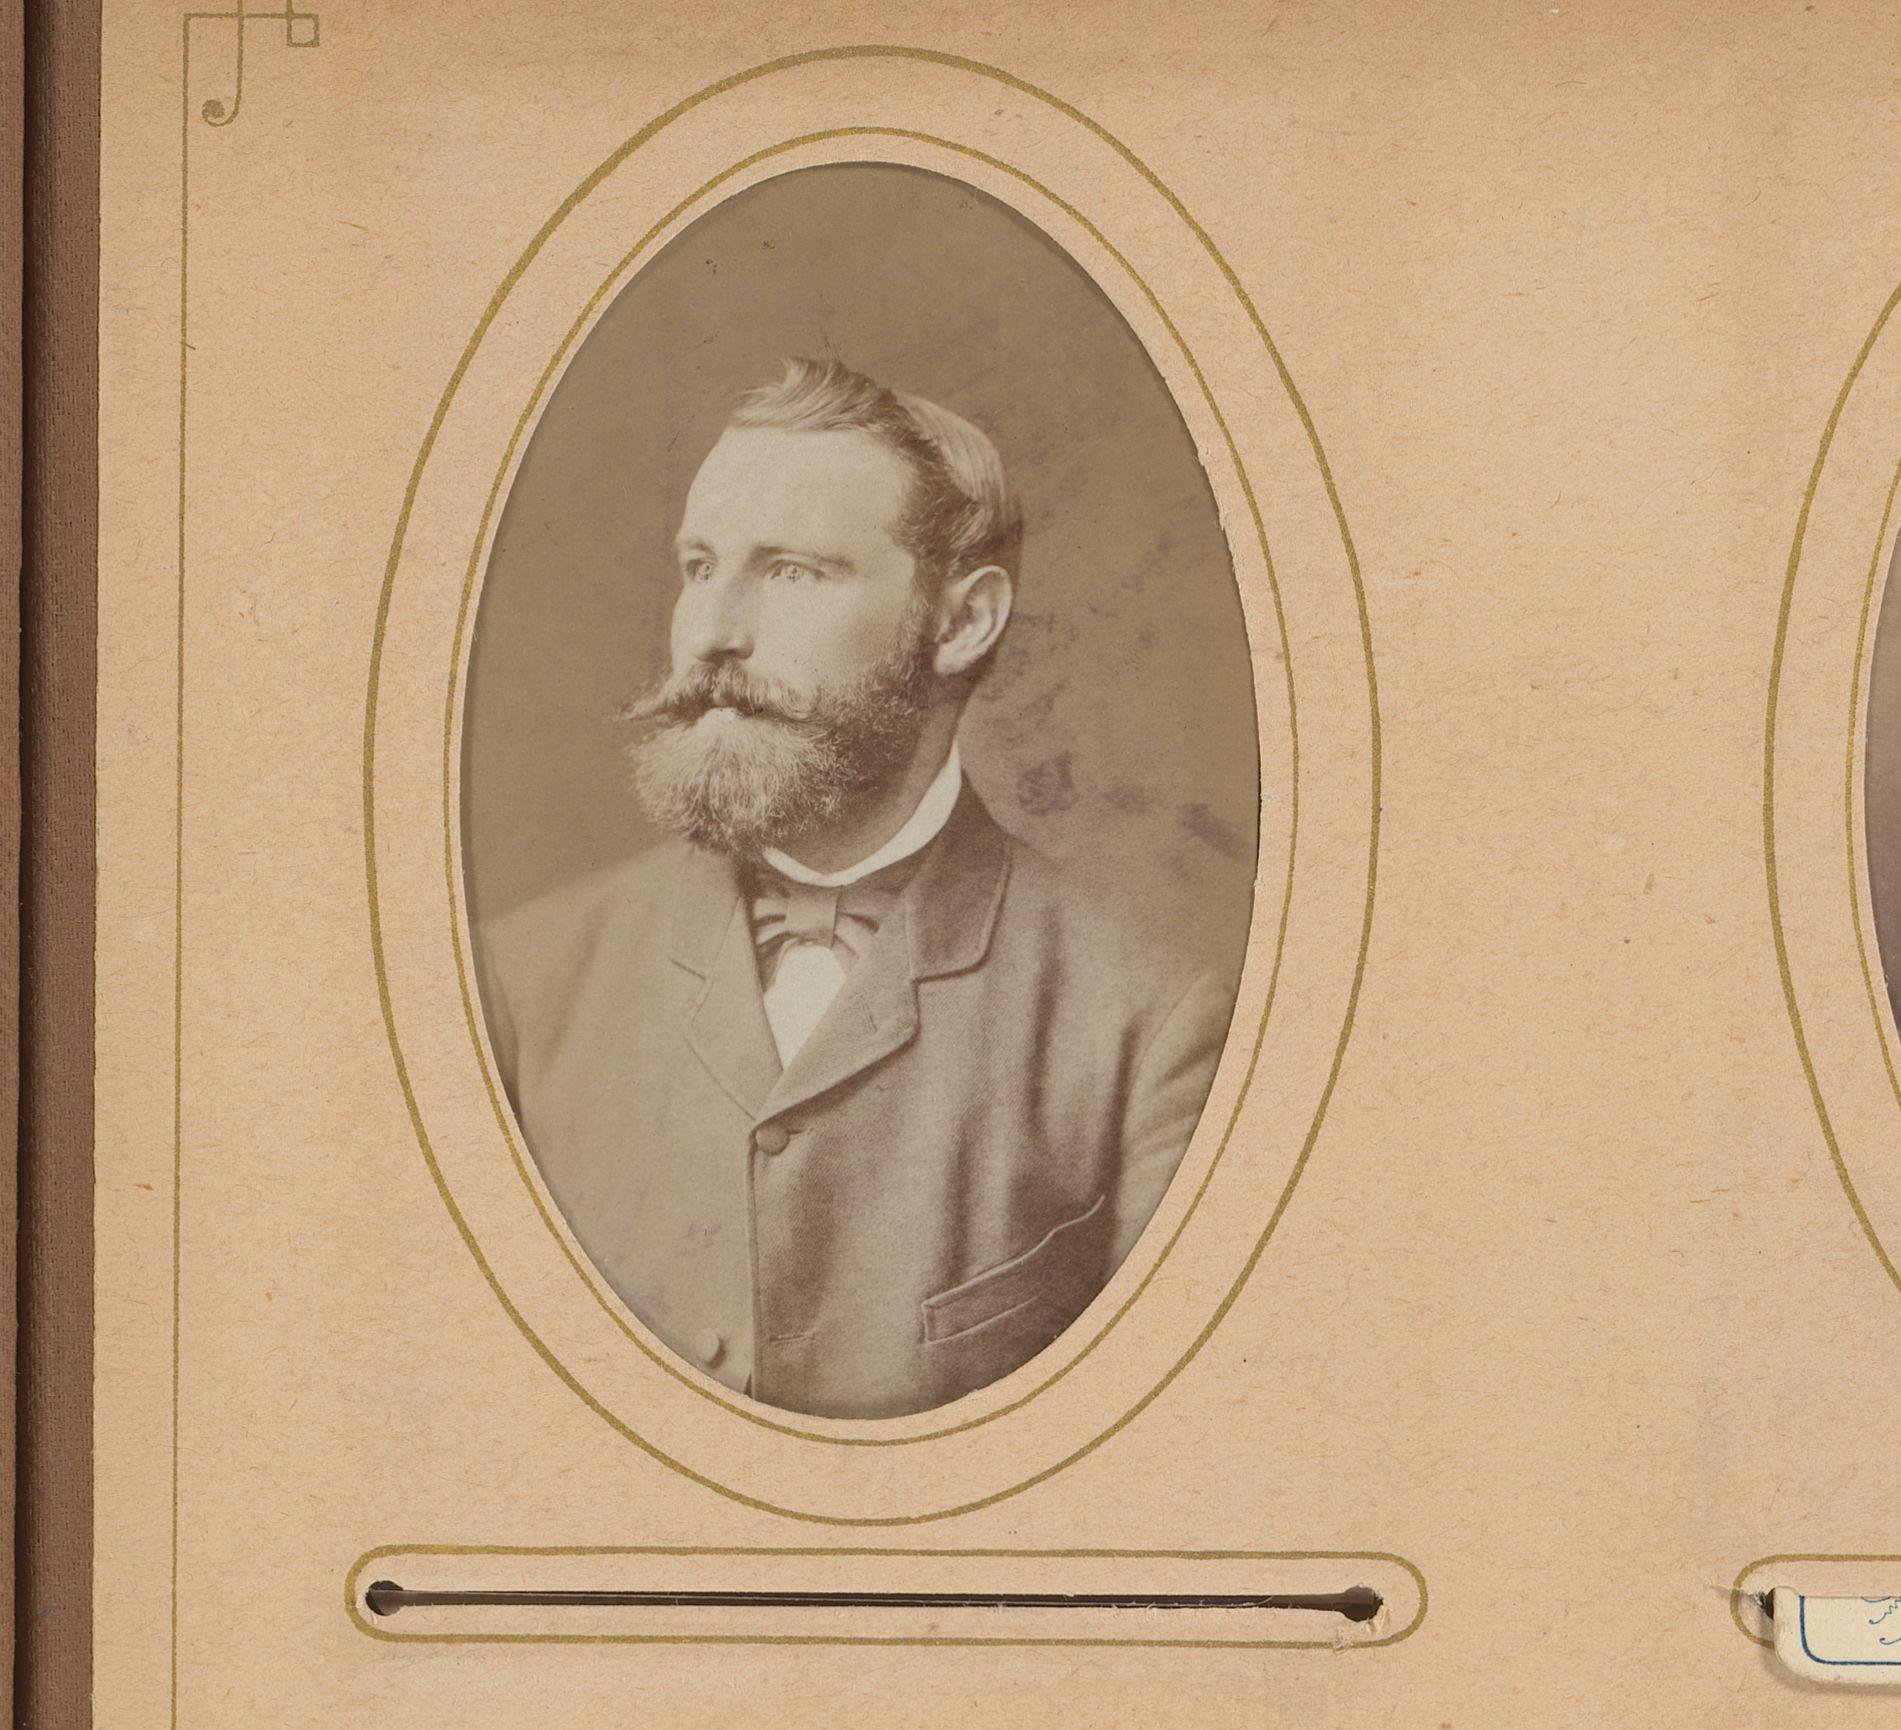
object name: photograph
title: Portret van een man met snor en baard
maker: ernst schroeter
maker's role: fotograaf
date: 1860-1900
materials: cardboard, photographic support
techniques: albumen print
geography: meissen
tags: moustache, historical persons, beard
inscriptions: inscription: ‘E. SCHROETER/ Photographisches Atelier/ 597, OBERGASSE 597./ MEISSEN.’